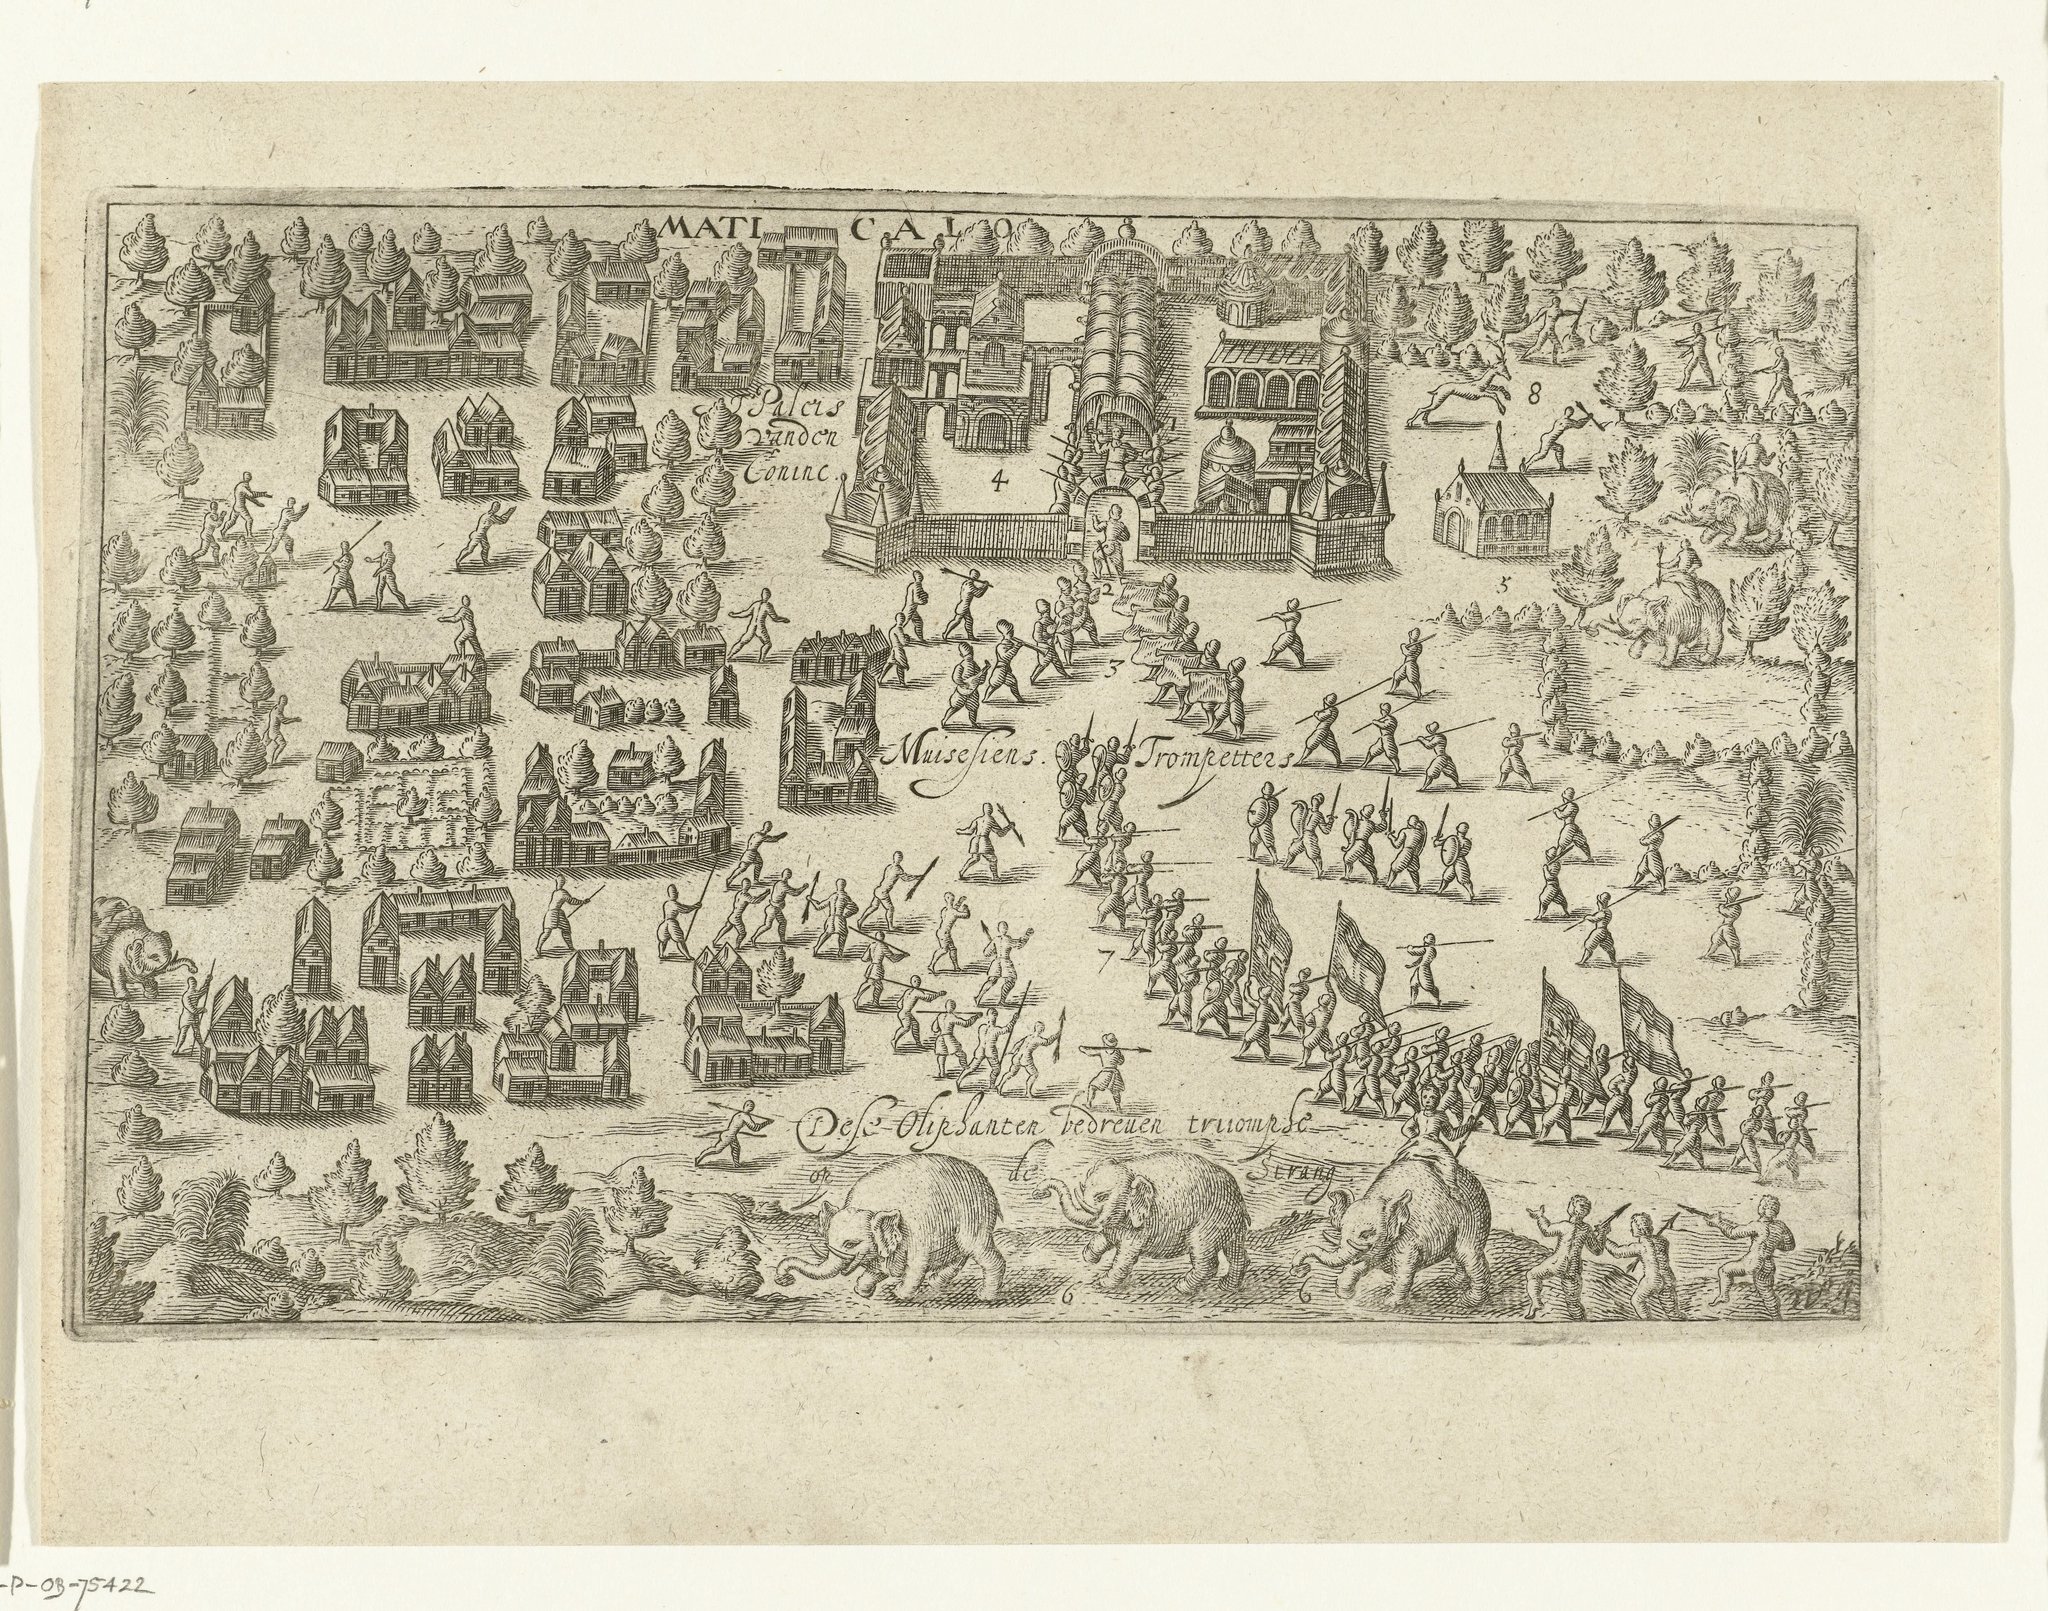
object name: print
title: Aankomst van Van Spilbergen te Batticaloa op Ceylon, 1602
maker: floris balthasarsz. van berckenrode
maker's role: print maker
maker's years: 1562-1616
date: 1603-1605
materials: paper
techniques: engraving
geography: northern netherlands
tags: antwerp, bergen op zoom, landscapes in tropical and sub-tropical regions, exploration, expedition, voyage of discovery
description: Gebruikt als illustratie eerst in: J. van Spilbergen, t'Historiael iournael, van tghene ghepasseert is van weghen drie schepen (...) onder tbeleyt van Ioris van Speilberghen generael, anno 1601 (...) tot in t'eylant Celon, Floris Balthasars, Delft, 1605. In deze staat gebruikt als illustratie in: 't Historiael Journael, van tghene ghepasseert is van weghen drie Schepen ghenaemt den Ram, Schaep, ende het lam, ghevaren uyt Zeelandt, van der Stadt Camp-Vere, naer d'Oost-Indien, onder 't beleyt van den heer Admirael Joris van Splibergen, gedaen in de Jaren 1601. 1602. 1603. ende 1604. Opgenomen in: I. Commelin, Begin ende voortgangh, van de Vereenighde Nederlantsche Geoctroyeerde Oost-Indische Compagnie, J. Janssonius, Amsterdam 1646. Genummerd: No. 4.